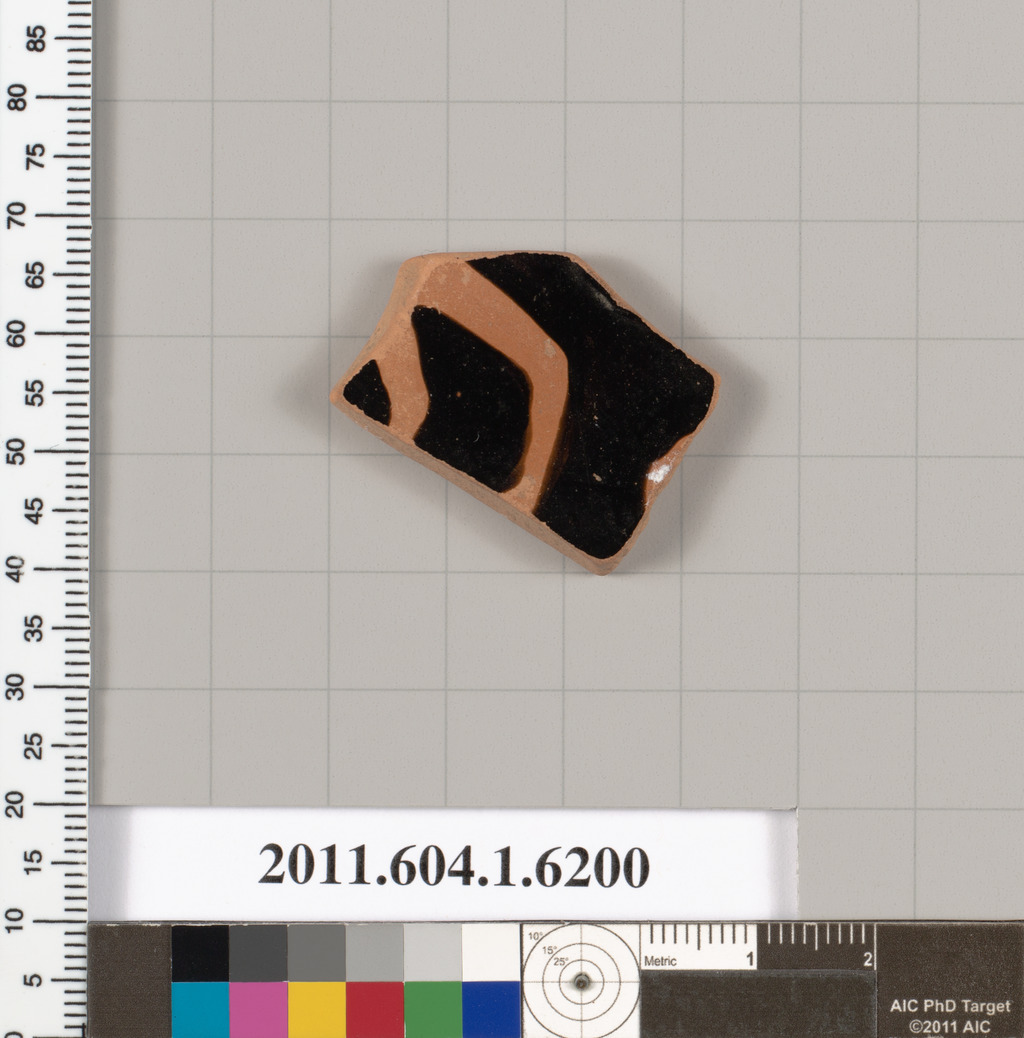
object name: kylix fragment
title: Terracotta fragment of a kylix (drinking cup)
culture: greek, attic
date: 510-500 BCE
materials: terracotta